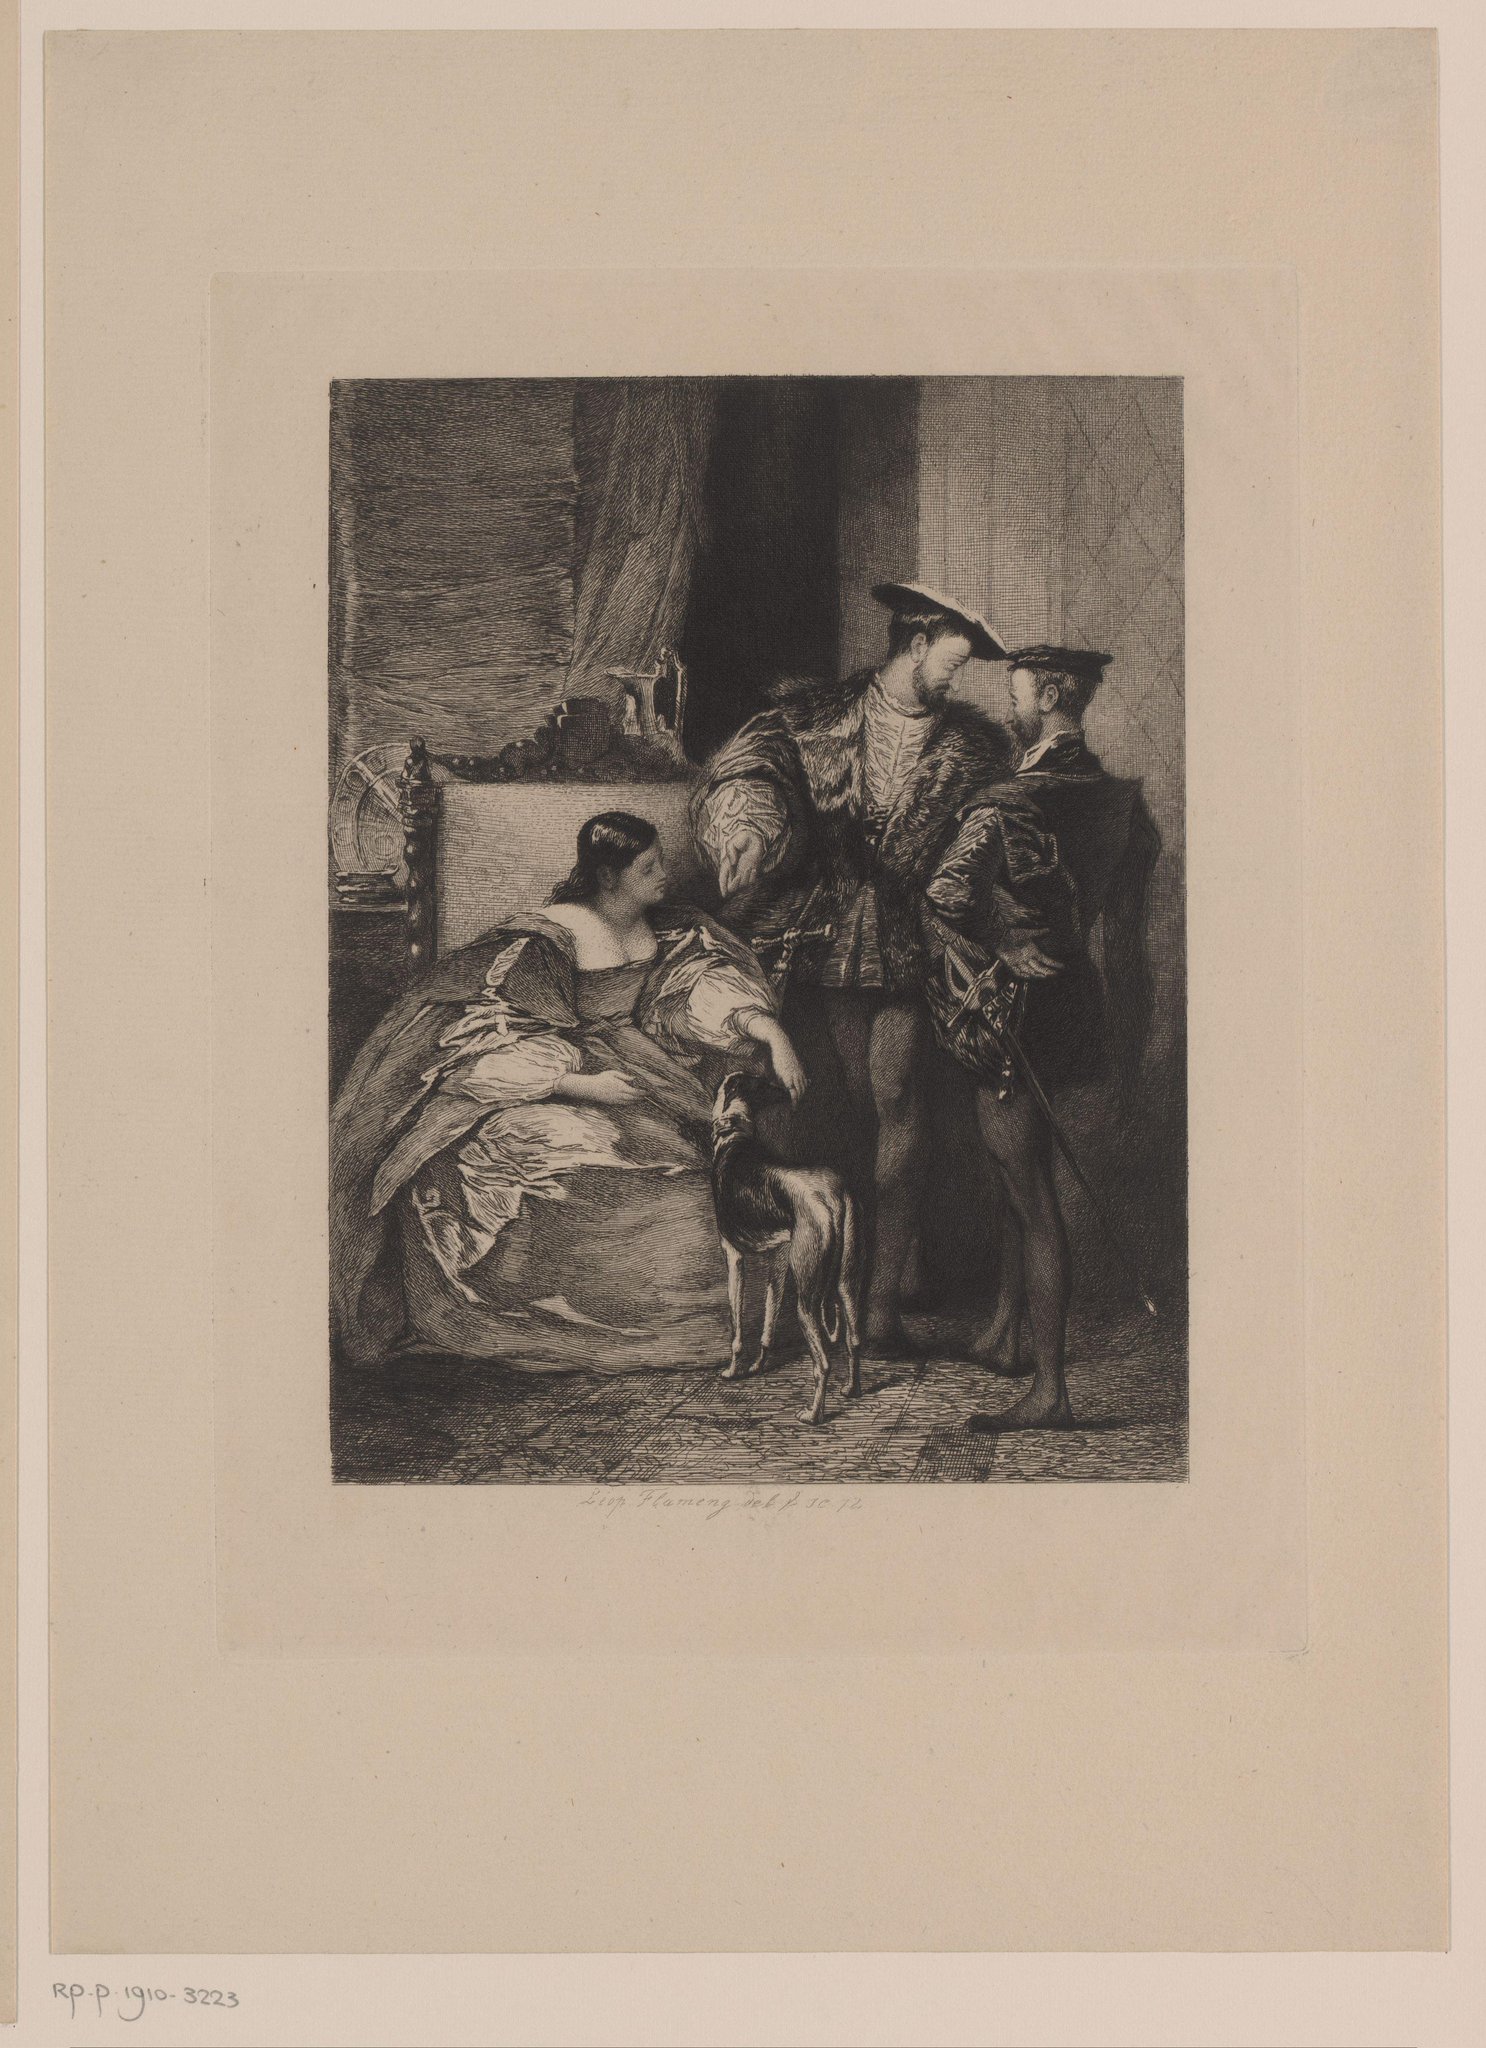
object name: print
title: Interieur met Frans I van Frankrijk, keizer Karel V en de hertogin van Étampes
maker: léopold flameng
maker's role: print maker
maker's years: 1831-1911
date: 1872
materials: paper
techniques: etching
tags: frans i van valois-angoulême (koning van frankrijk), ghent, charles v (holy roman emperor and king of spain), historical person (with name) - historical person (with name) portrayed in a group, in a group-portrait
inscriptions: collector's mark: Lugt 2228